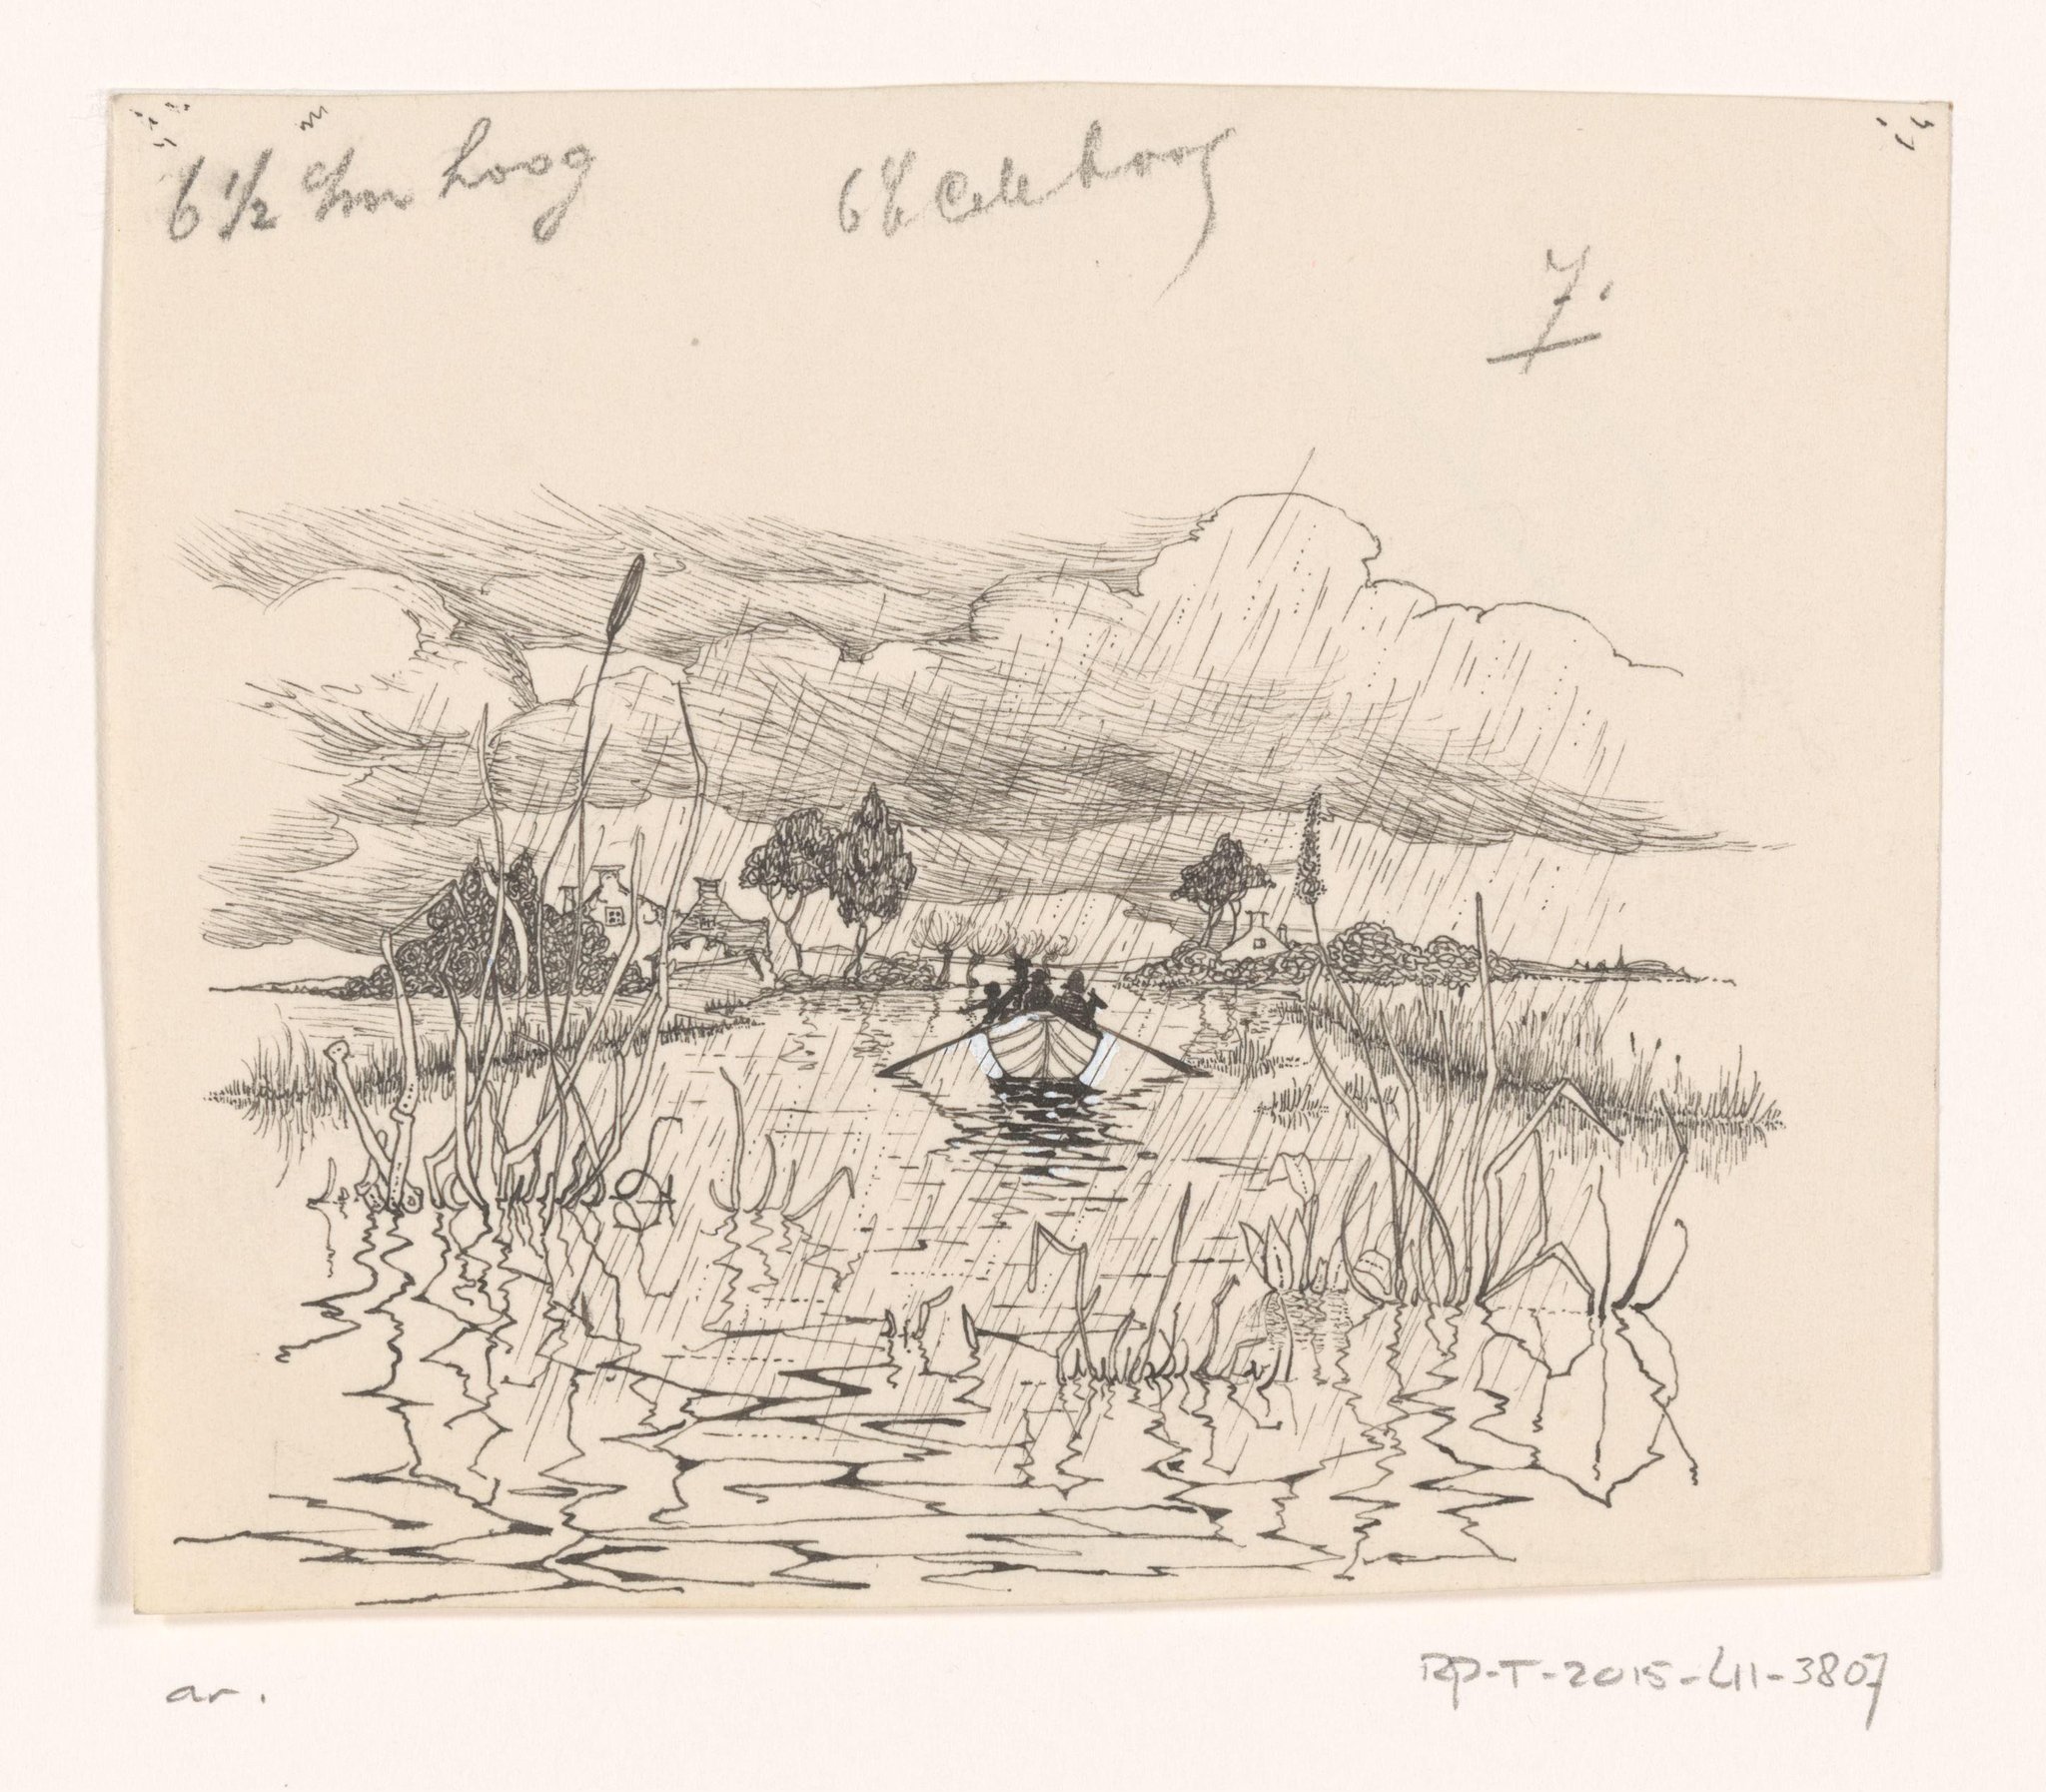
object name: boekillustratie ontwerp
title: Gezin in boot in de regen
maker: Anonymous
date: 1890-1930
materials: paint, ink, paper, pencil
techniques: brush, pen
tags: rowing-boat, canoe, etc., rain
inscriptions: :, number: ‘7.’, collector's mark: Lugt 2228a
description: Een gezin vaart over een rivier in de regen.